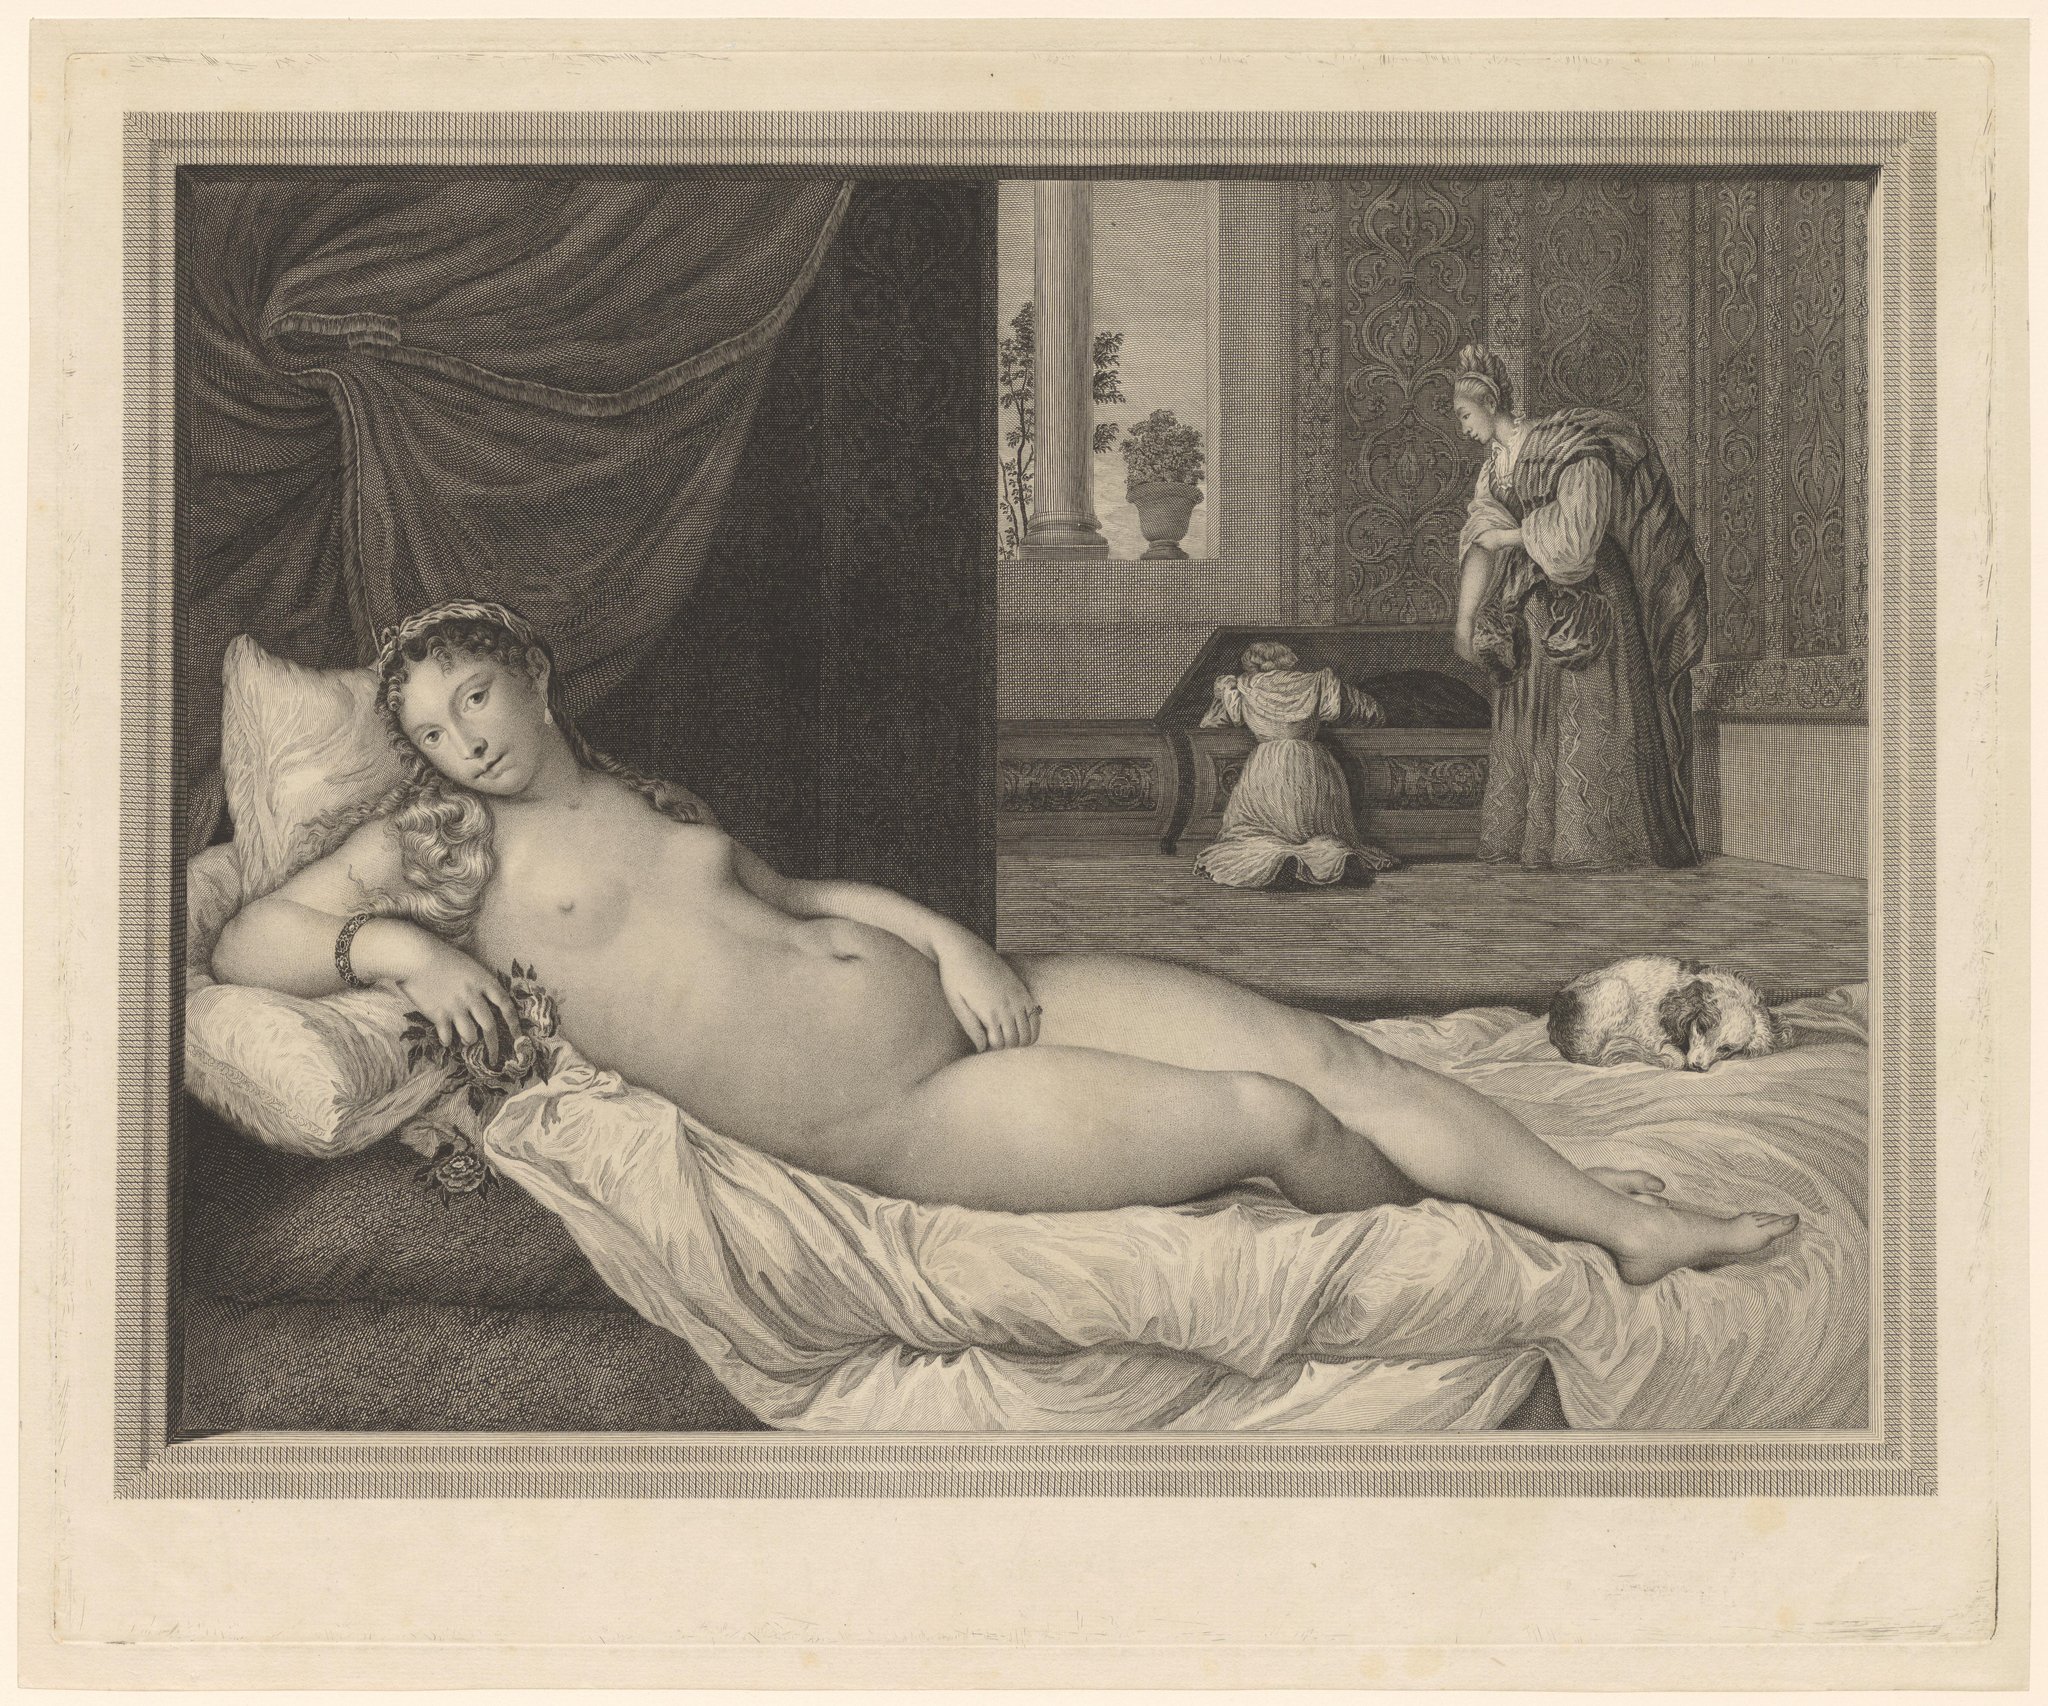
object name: print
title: Venus van Urbino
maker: robert strange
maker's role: print maker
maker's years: 1721-1792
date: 1768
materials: paper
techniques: engraving, etching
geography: london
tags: (story of) venus (aphrodite)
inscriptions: collector's mark: Lugt 2228